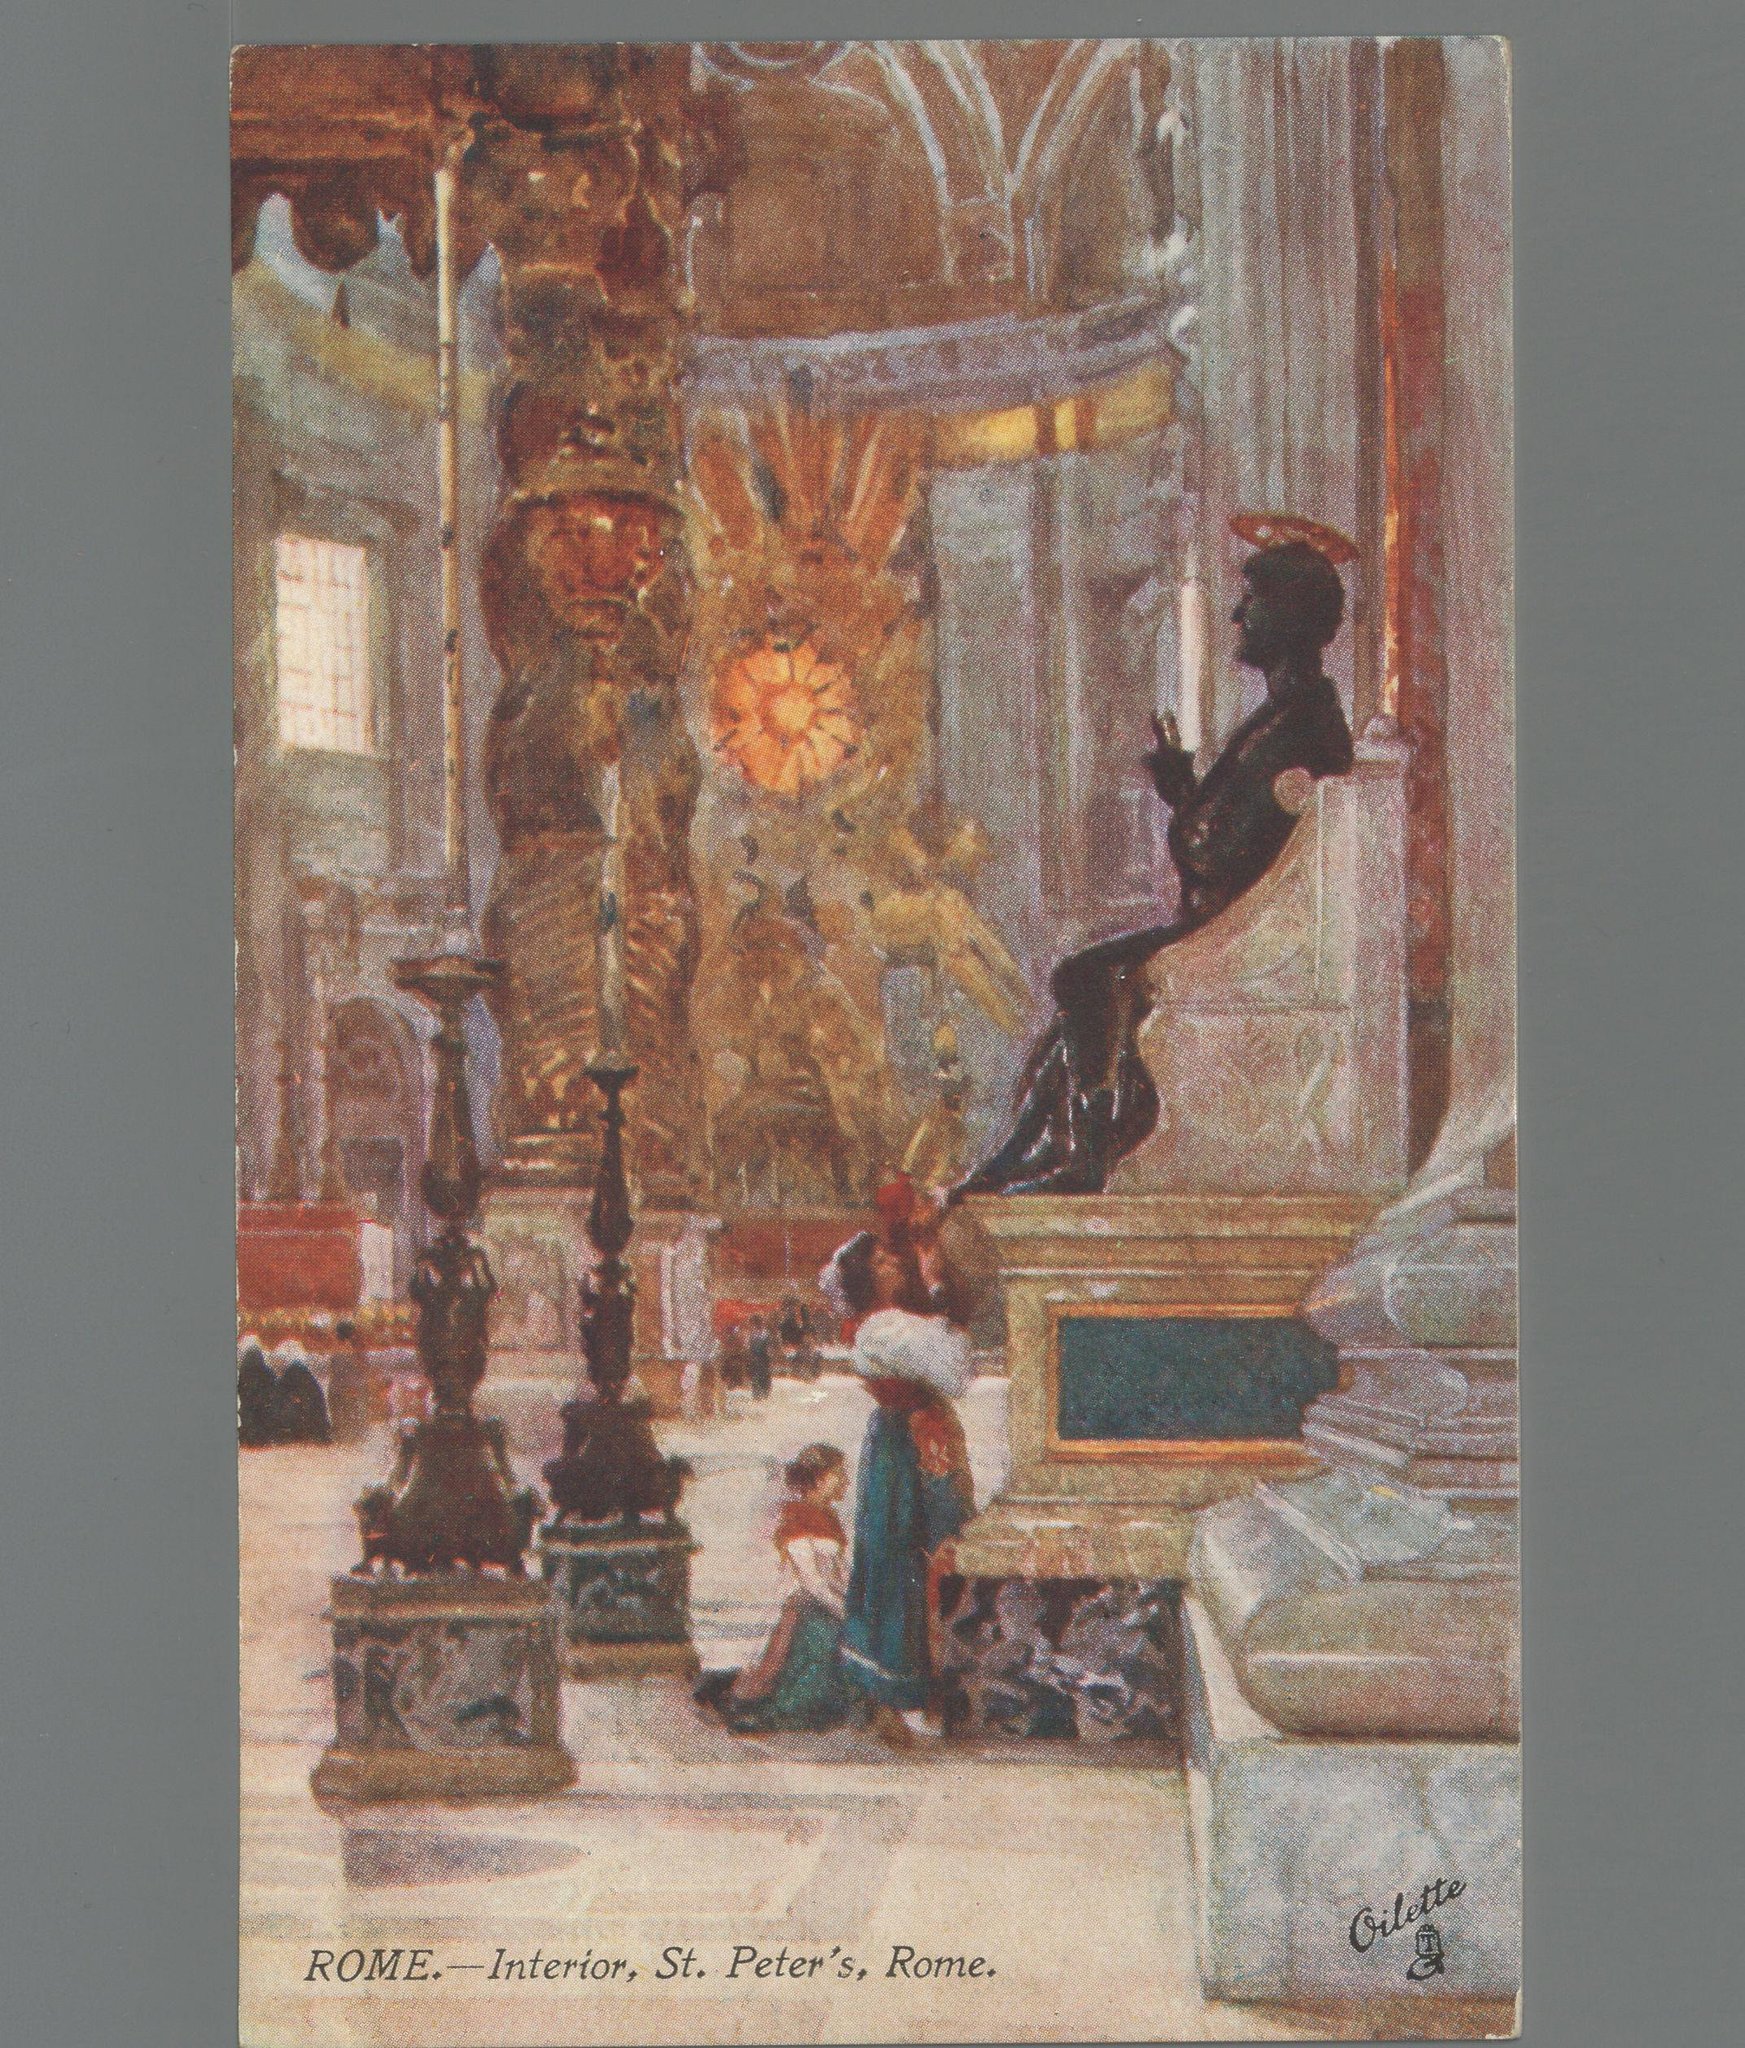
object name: ansichtkaart, prentbriefkaart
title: Wide Wide World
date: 1908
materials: cardboard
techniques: three-color autotype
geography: london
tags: interior of church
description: Afbeelding afkomstig uit: Malleson, Hope, en Mark Turner. Rome Painted By Alberto Pisa. Londen: Adam en Charles Black, 1905.